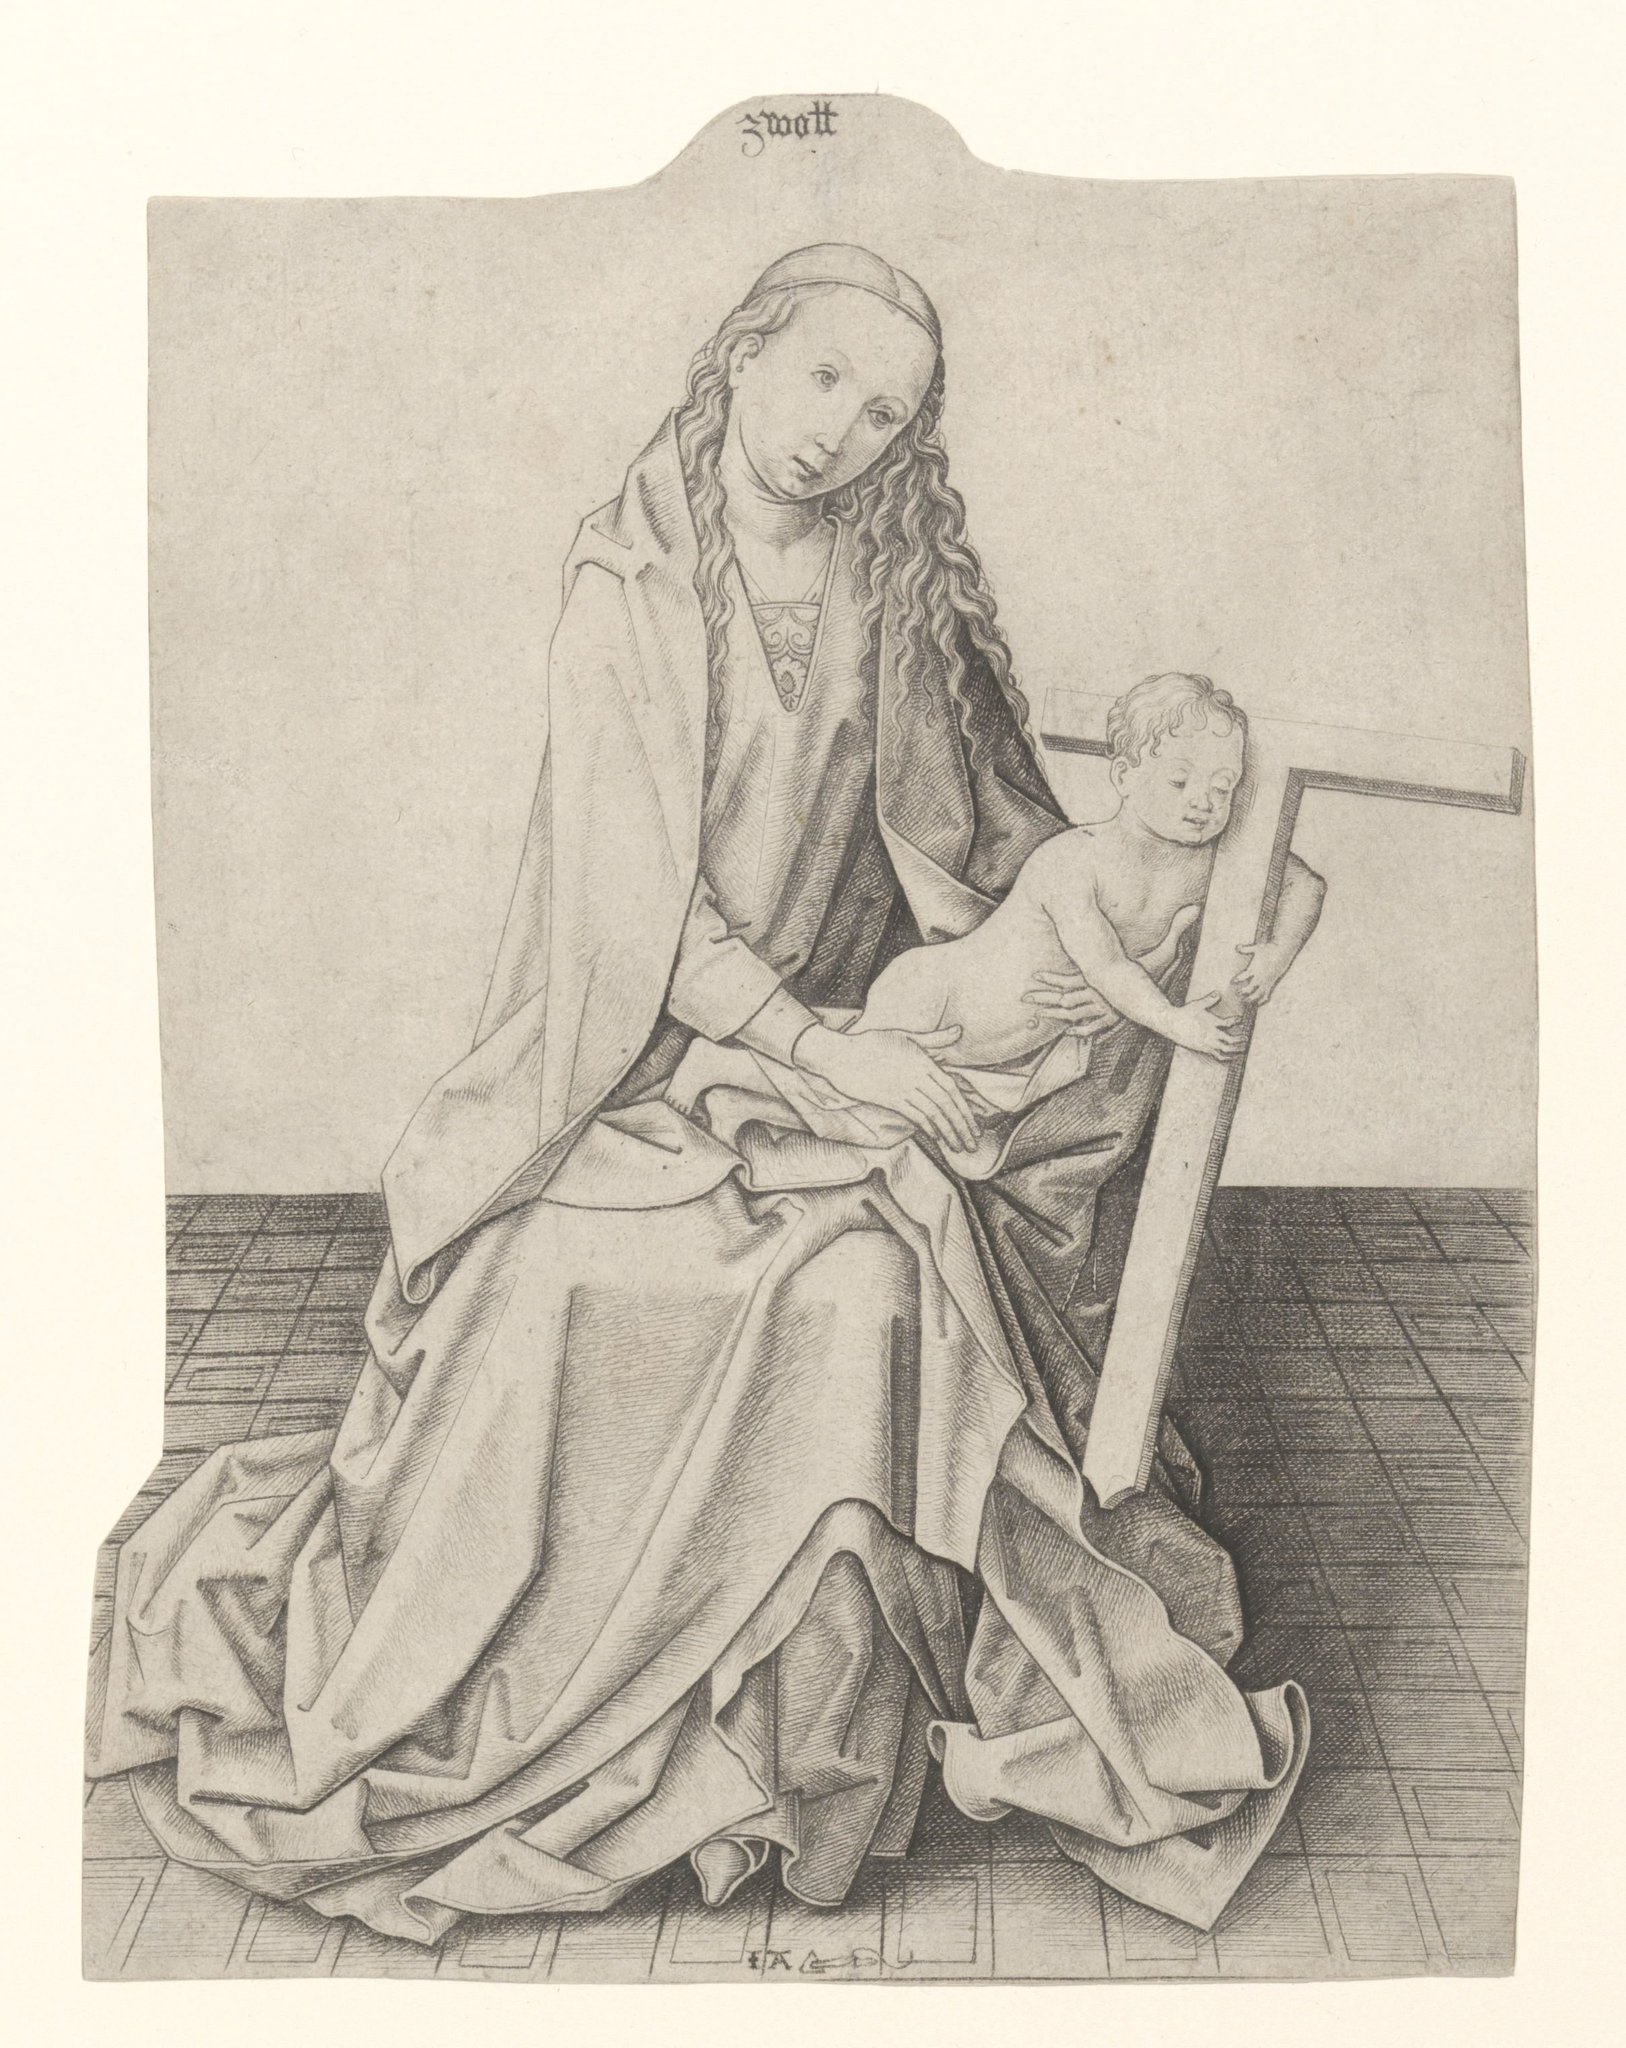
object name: print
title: The Virgin Mary with the Christ Child Holding a Cross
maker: monogrammist iam van zwolle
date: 1465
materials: paper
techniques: engraving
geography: low countries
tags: christ-child holding something in his hand, e.g. apple, bird, cherries, crucifix, grapes, paper wind-mill ~ madonna-representations, mary sitting or enthroned, the christ-child on her knee (christ-child to mary's left)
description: As mandated by the donor, the Waller-Fonds priority is to collect the earliest Dutch prints. However, they are extremely rare and hardly ever come on the market. Nevertheless, in recent years, with the help of other funds, it has been possible to acquire a number of seminal 15th-century works, including this touching engraving by a silversmith active in Zwolle.